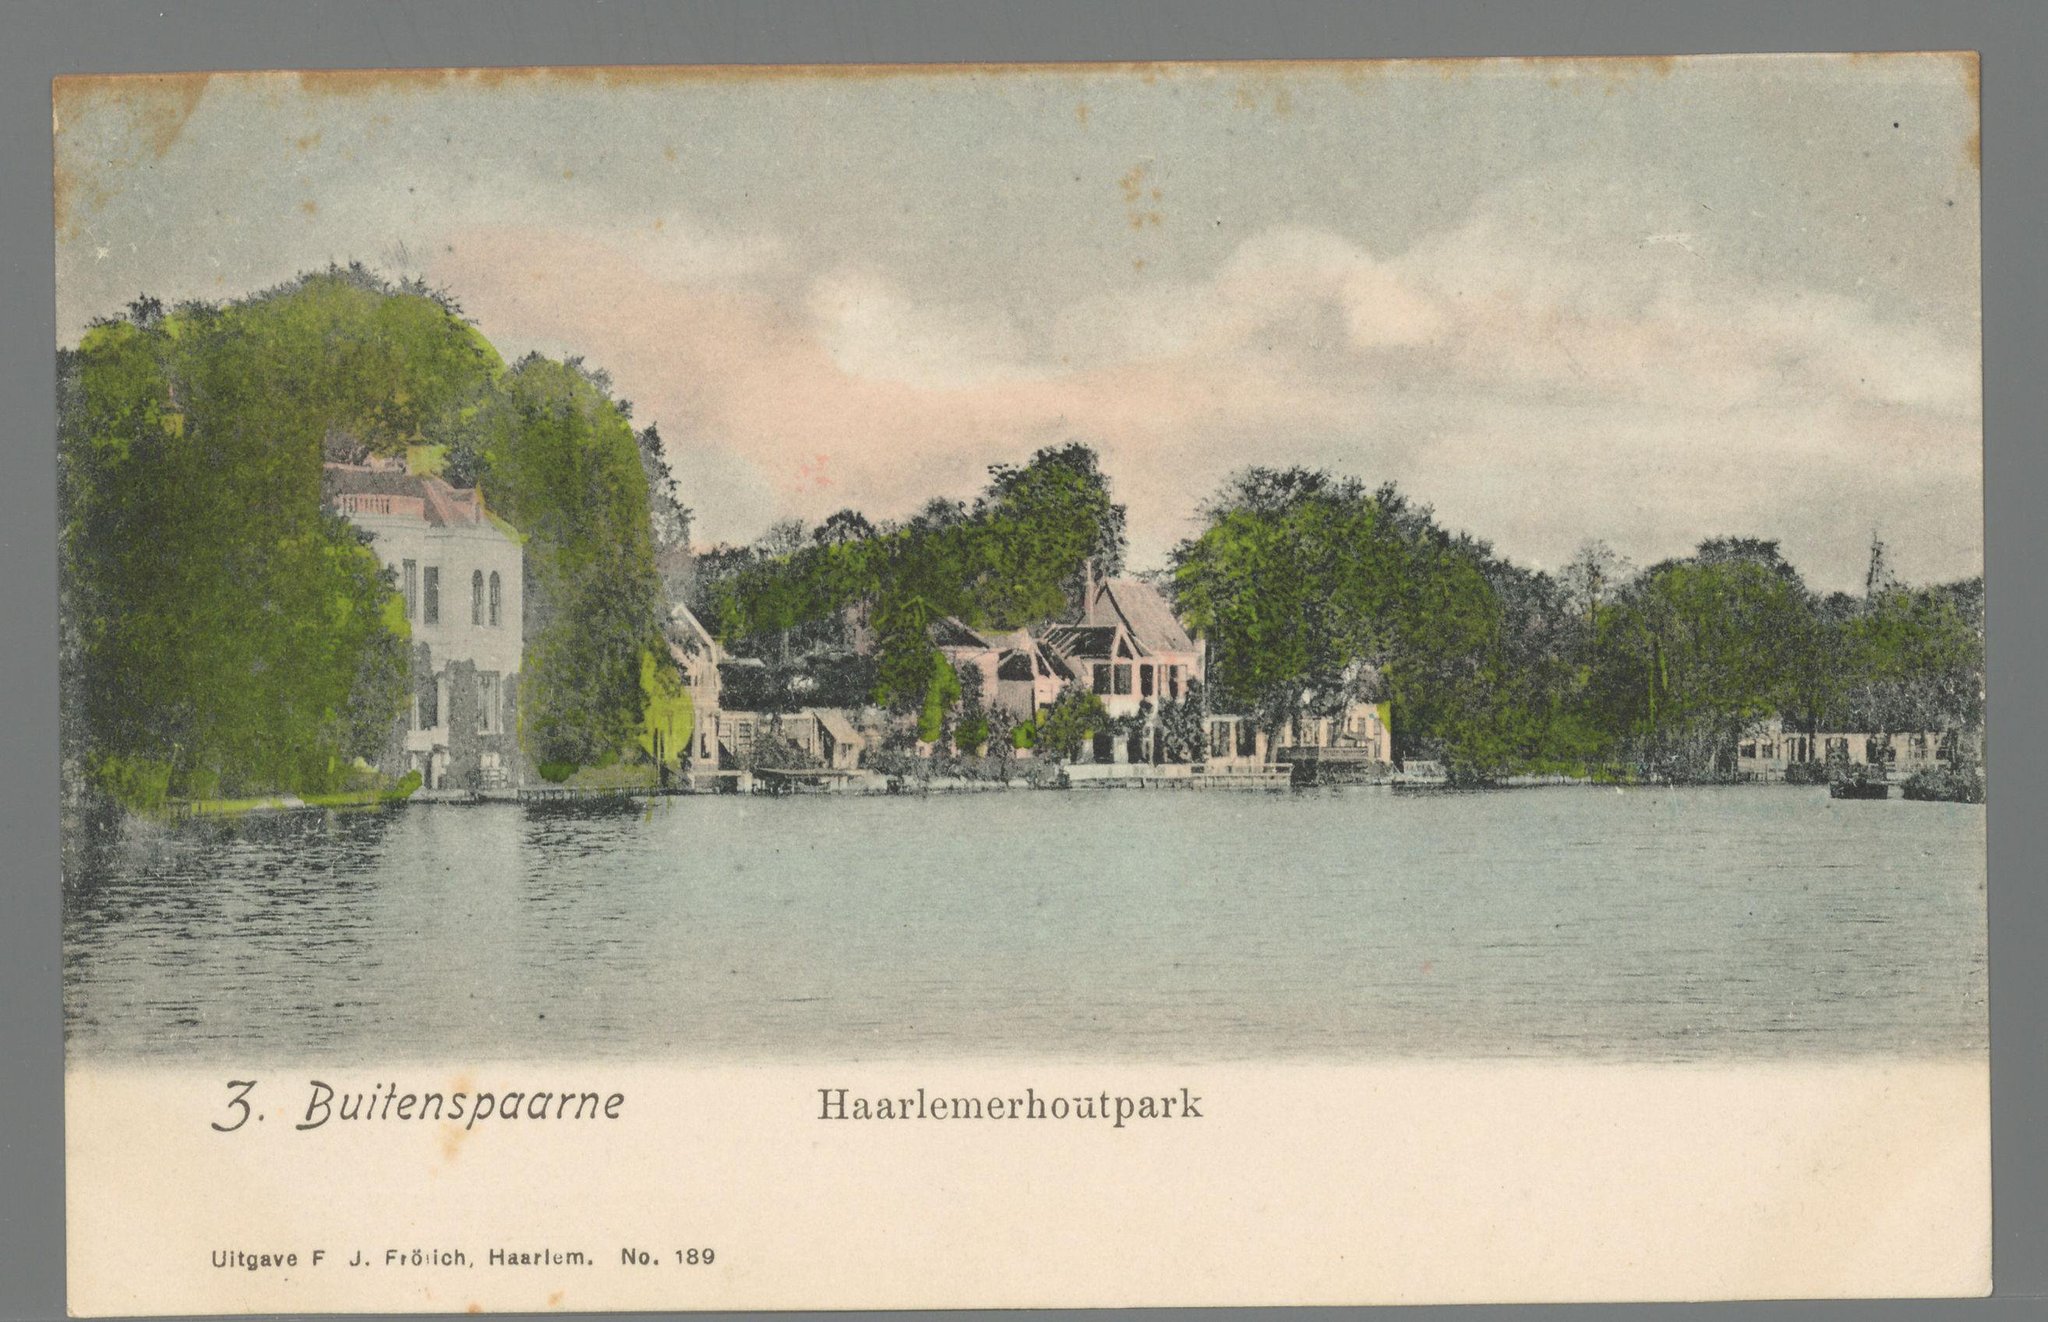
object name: photomechanical print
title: Buitenspaarne. Haarlemmerhoutpark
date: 1892-1905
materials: cardboard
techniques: photograph, hand coloring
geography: haarlem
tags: lake, forest, wood, haarlem